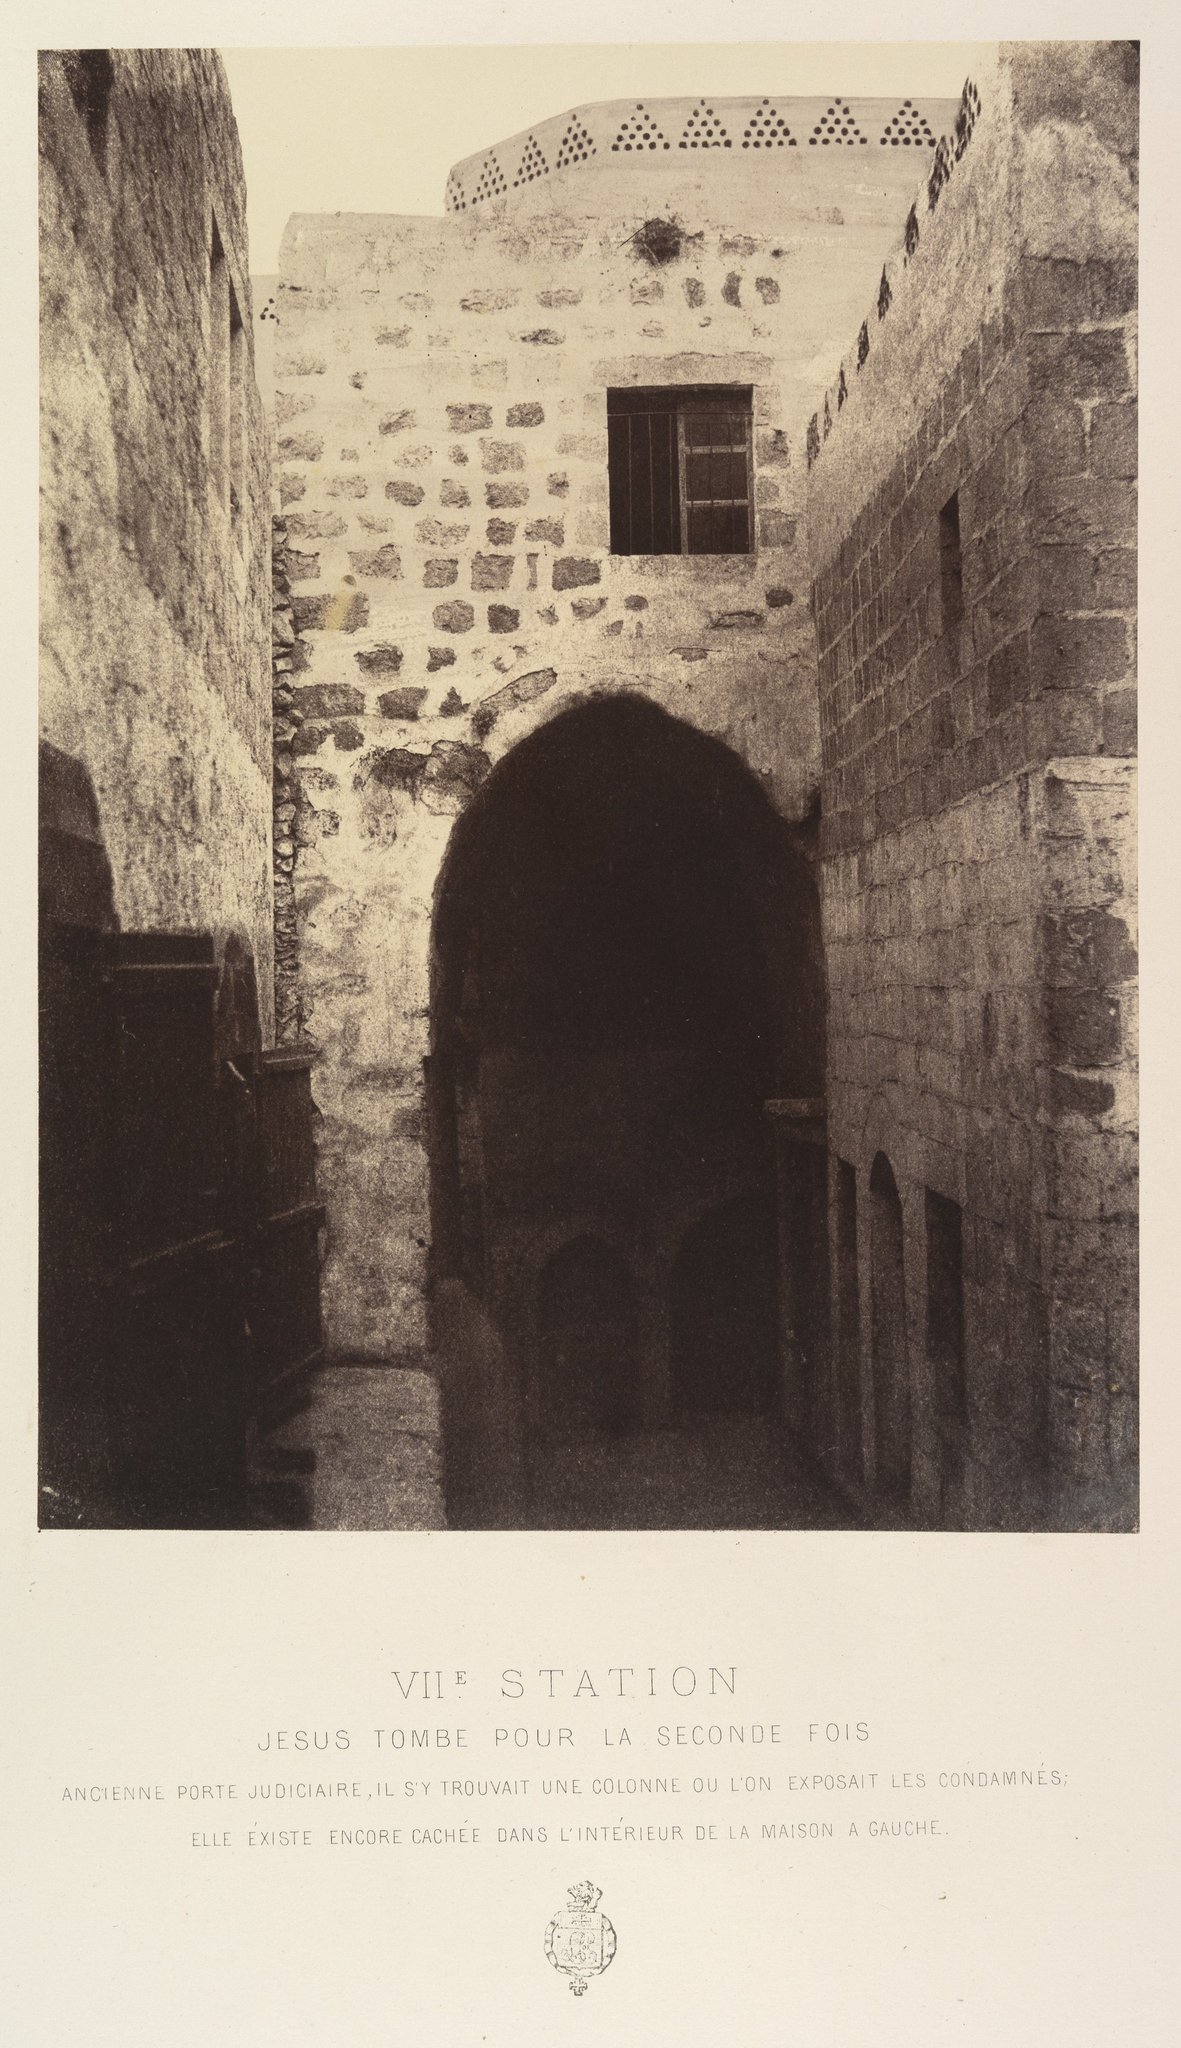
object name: photograph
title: VIIe Station. Jésus tombe pour la seconde fois. Ancienne porte judiciaire, il s'y trouvait une colonne ou l'on exposait les condamnés; Elle éxiste encore cachée dans l'intérieur de la maison a gauche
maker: louis de clercq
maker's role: artist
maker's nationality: french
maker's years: 1837-1901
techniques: albumen silver print, paper negative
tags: architecture,arches